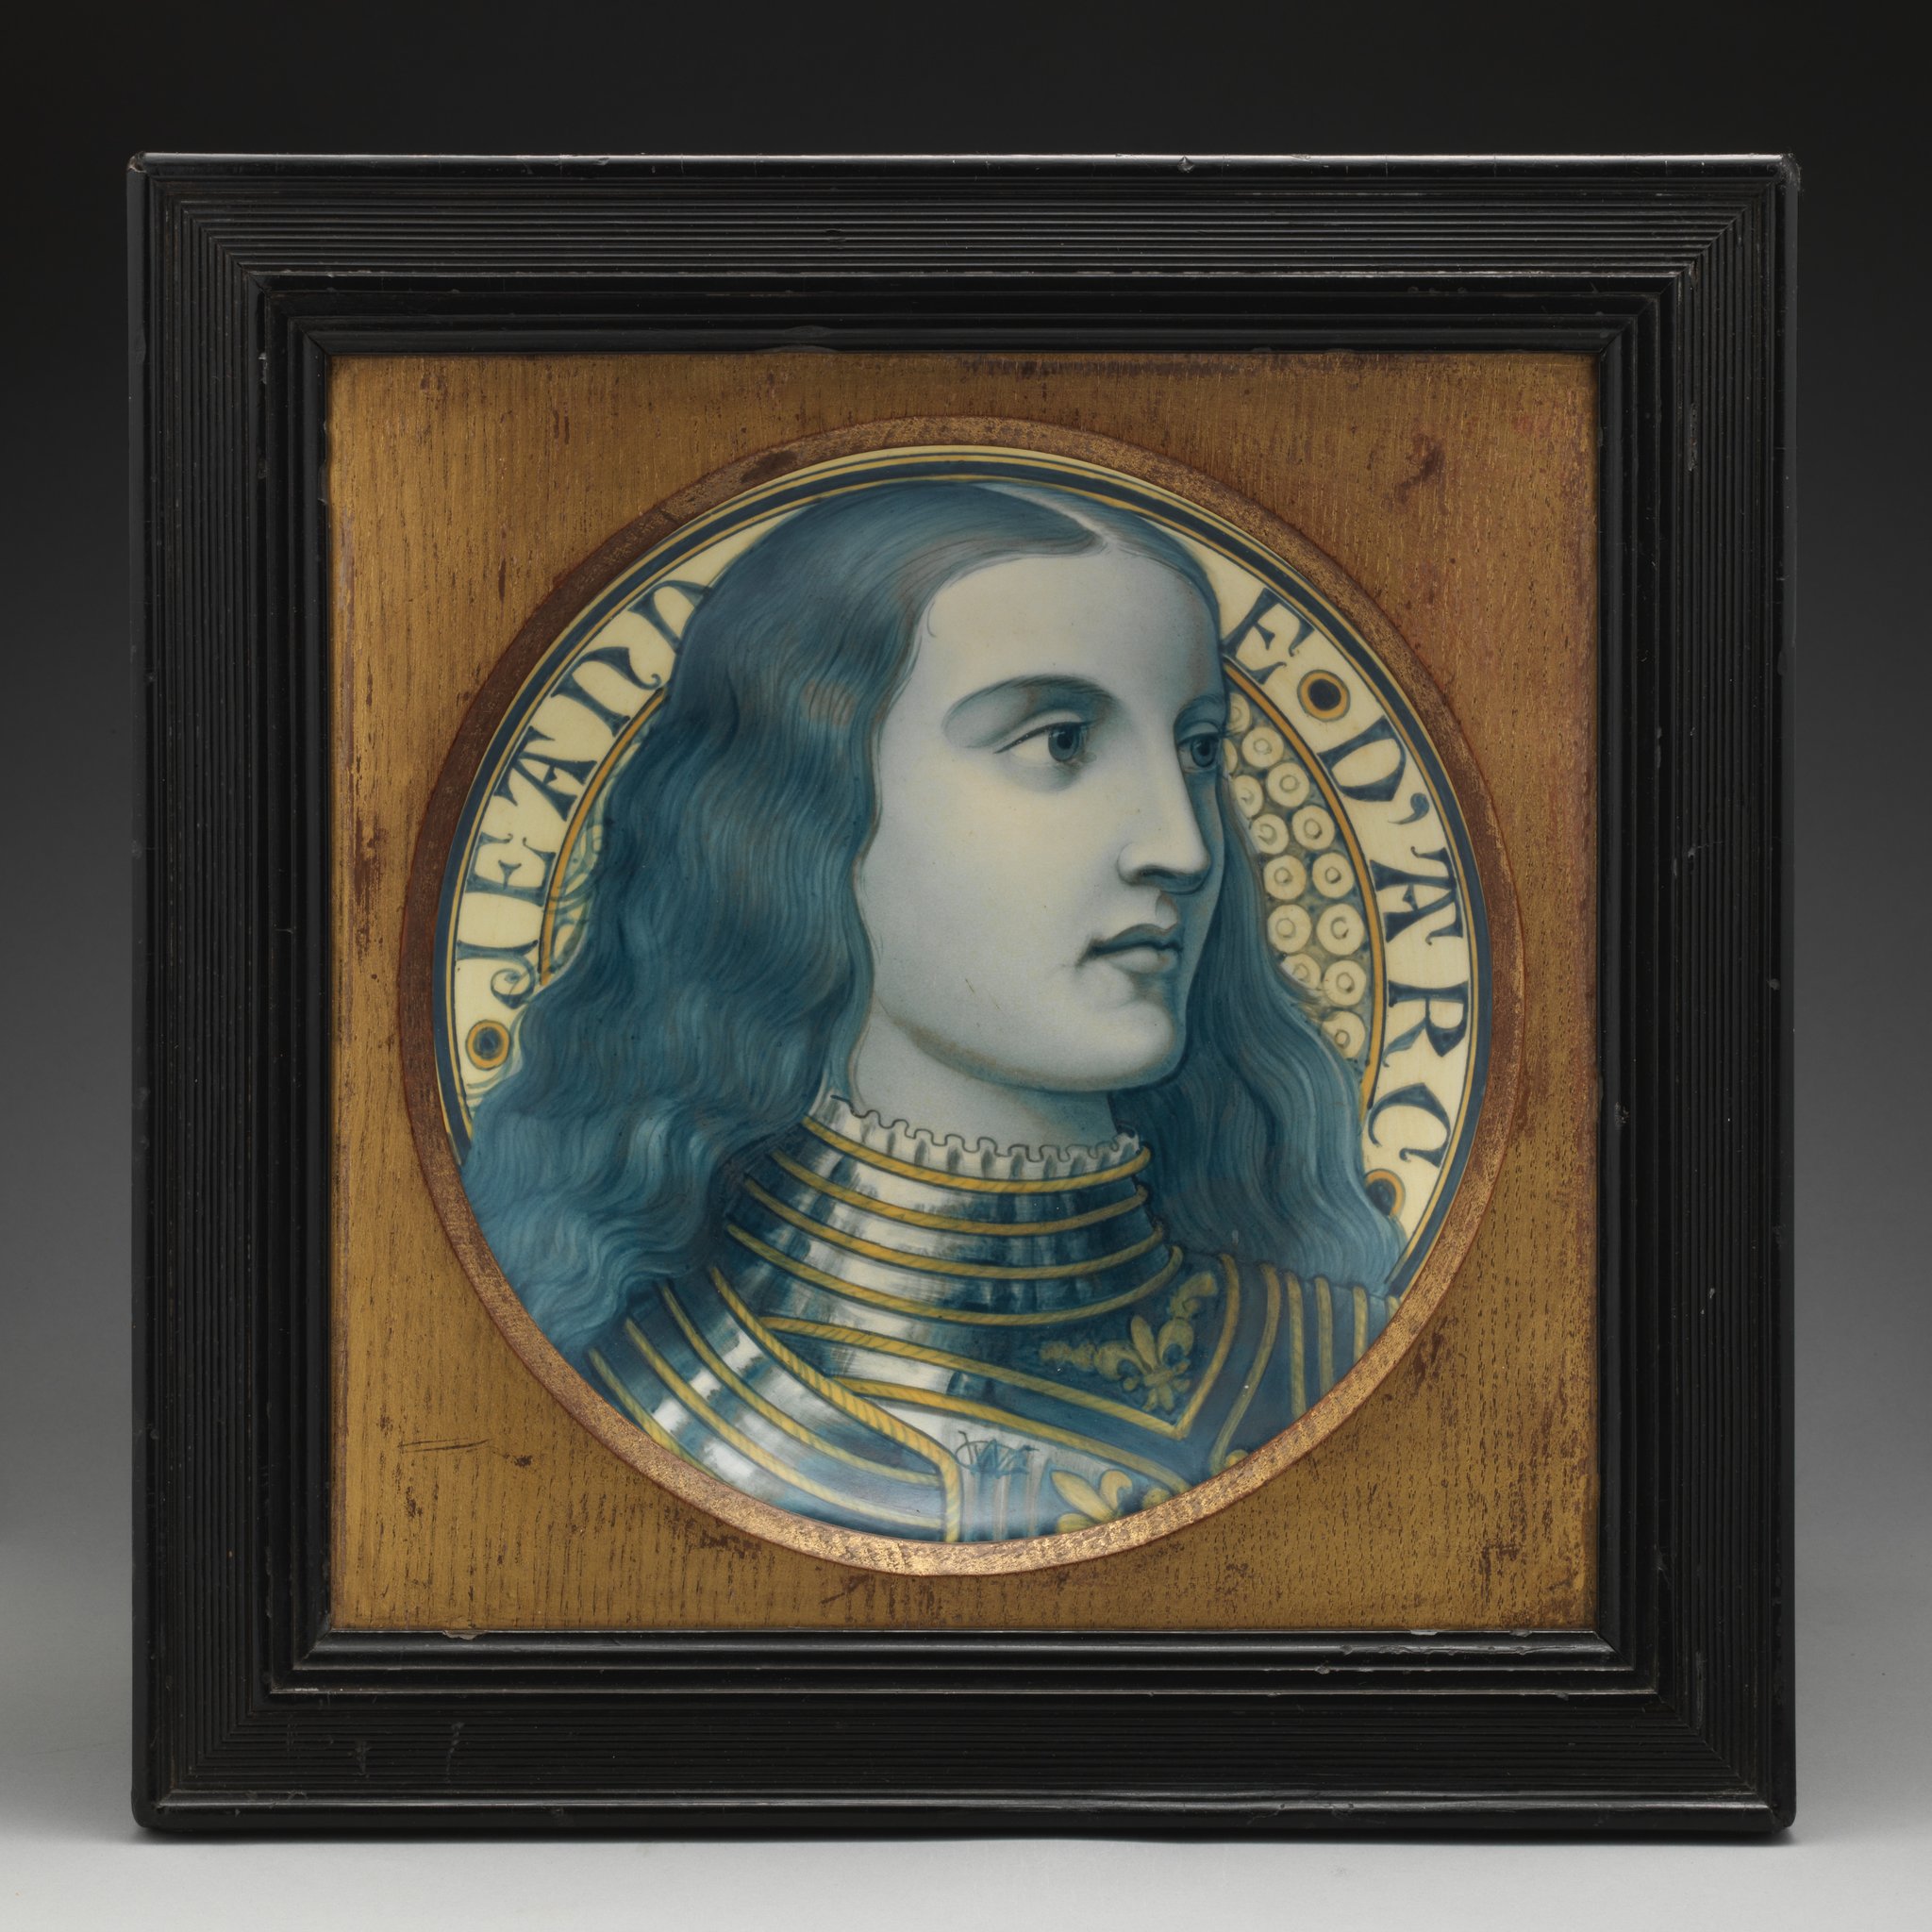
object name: plate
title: Plate with Joan of Arc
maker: howell & james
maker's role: retailer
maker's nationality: british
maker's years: 1819-1911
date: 1878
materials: earthenware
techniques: painting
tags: women